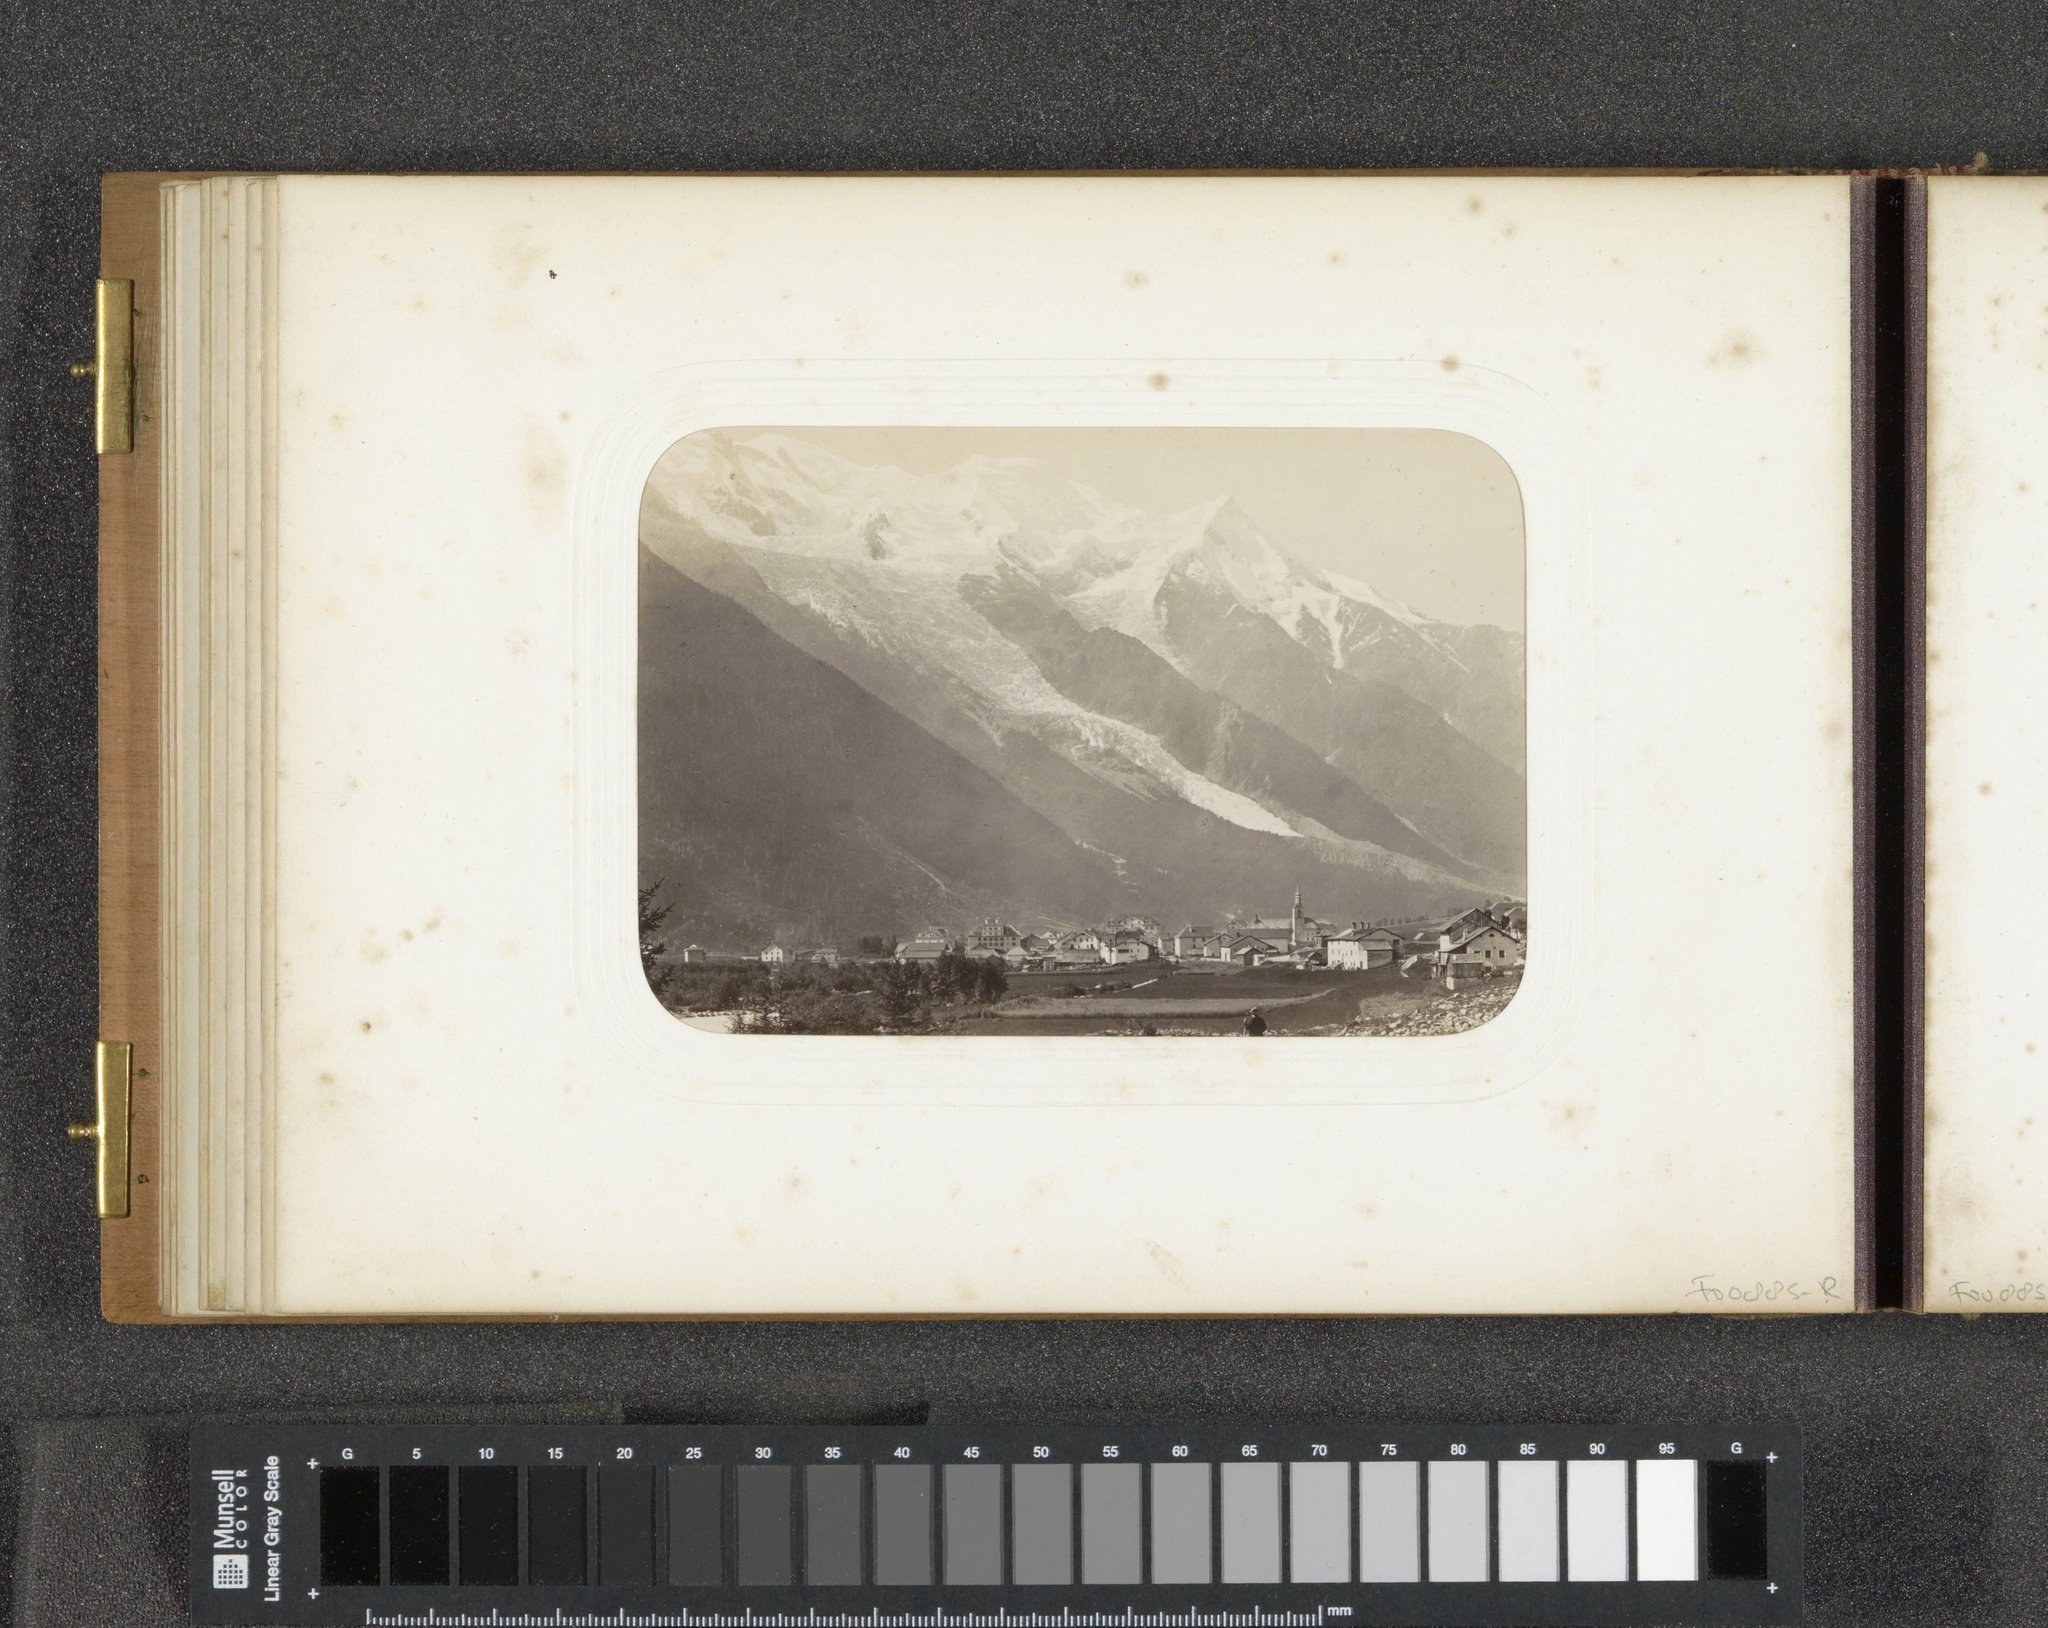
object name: cabinet photograph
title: Chamonix et le Mont Blanc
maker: auguste garcin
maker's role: fotograaf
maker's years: 1816-1895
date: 1860-1880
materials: cardboard, paper, photographic support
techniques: albumen print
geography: chamonix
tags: prospect of village, silhouette of village, mountains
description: Onderdeel van Reisalbum met bezienswaardigheden in de Zwitserse Alpen.